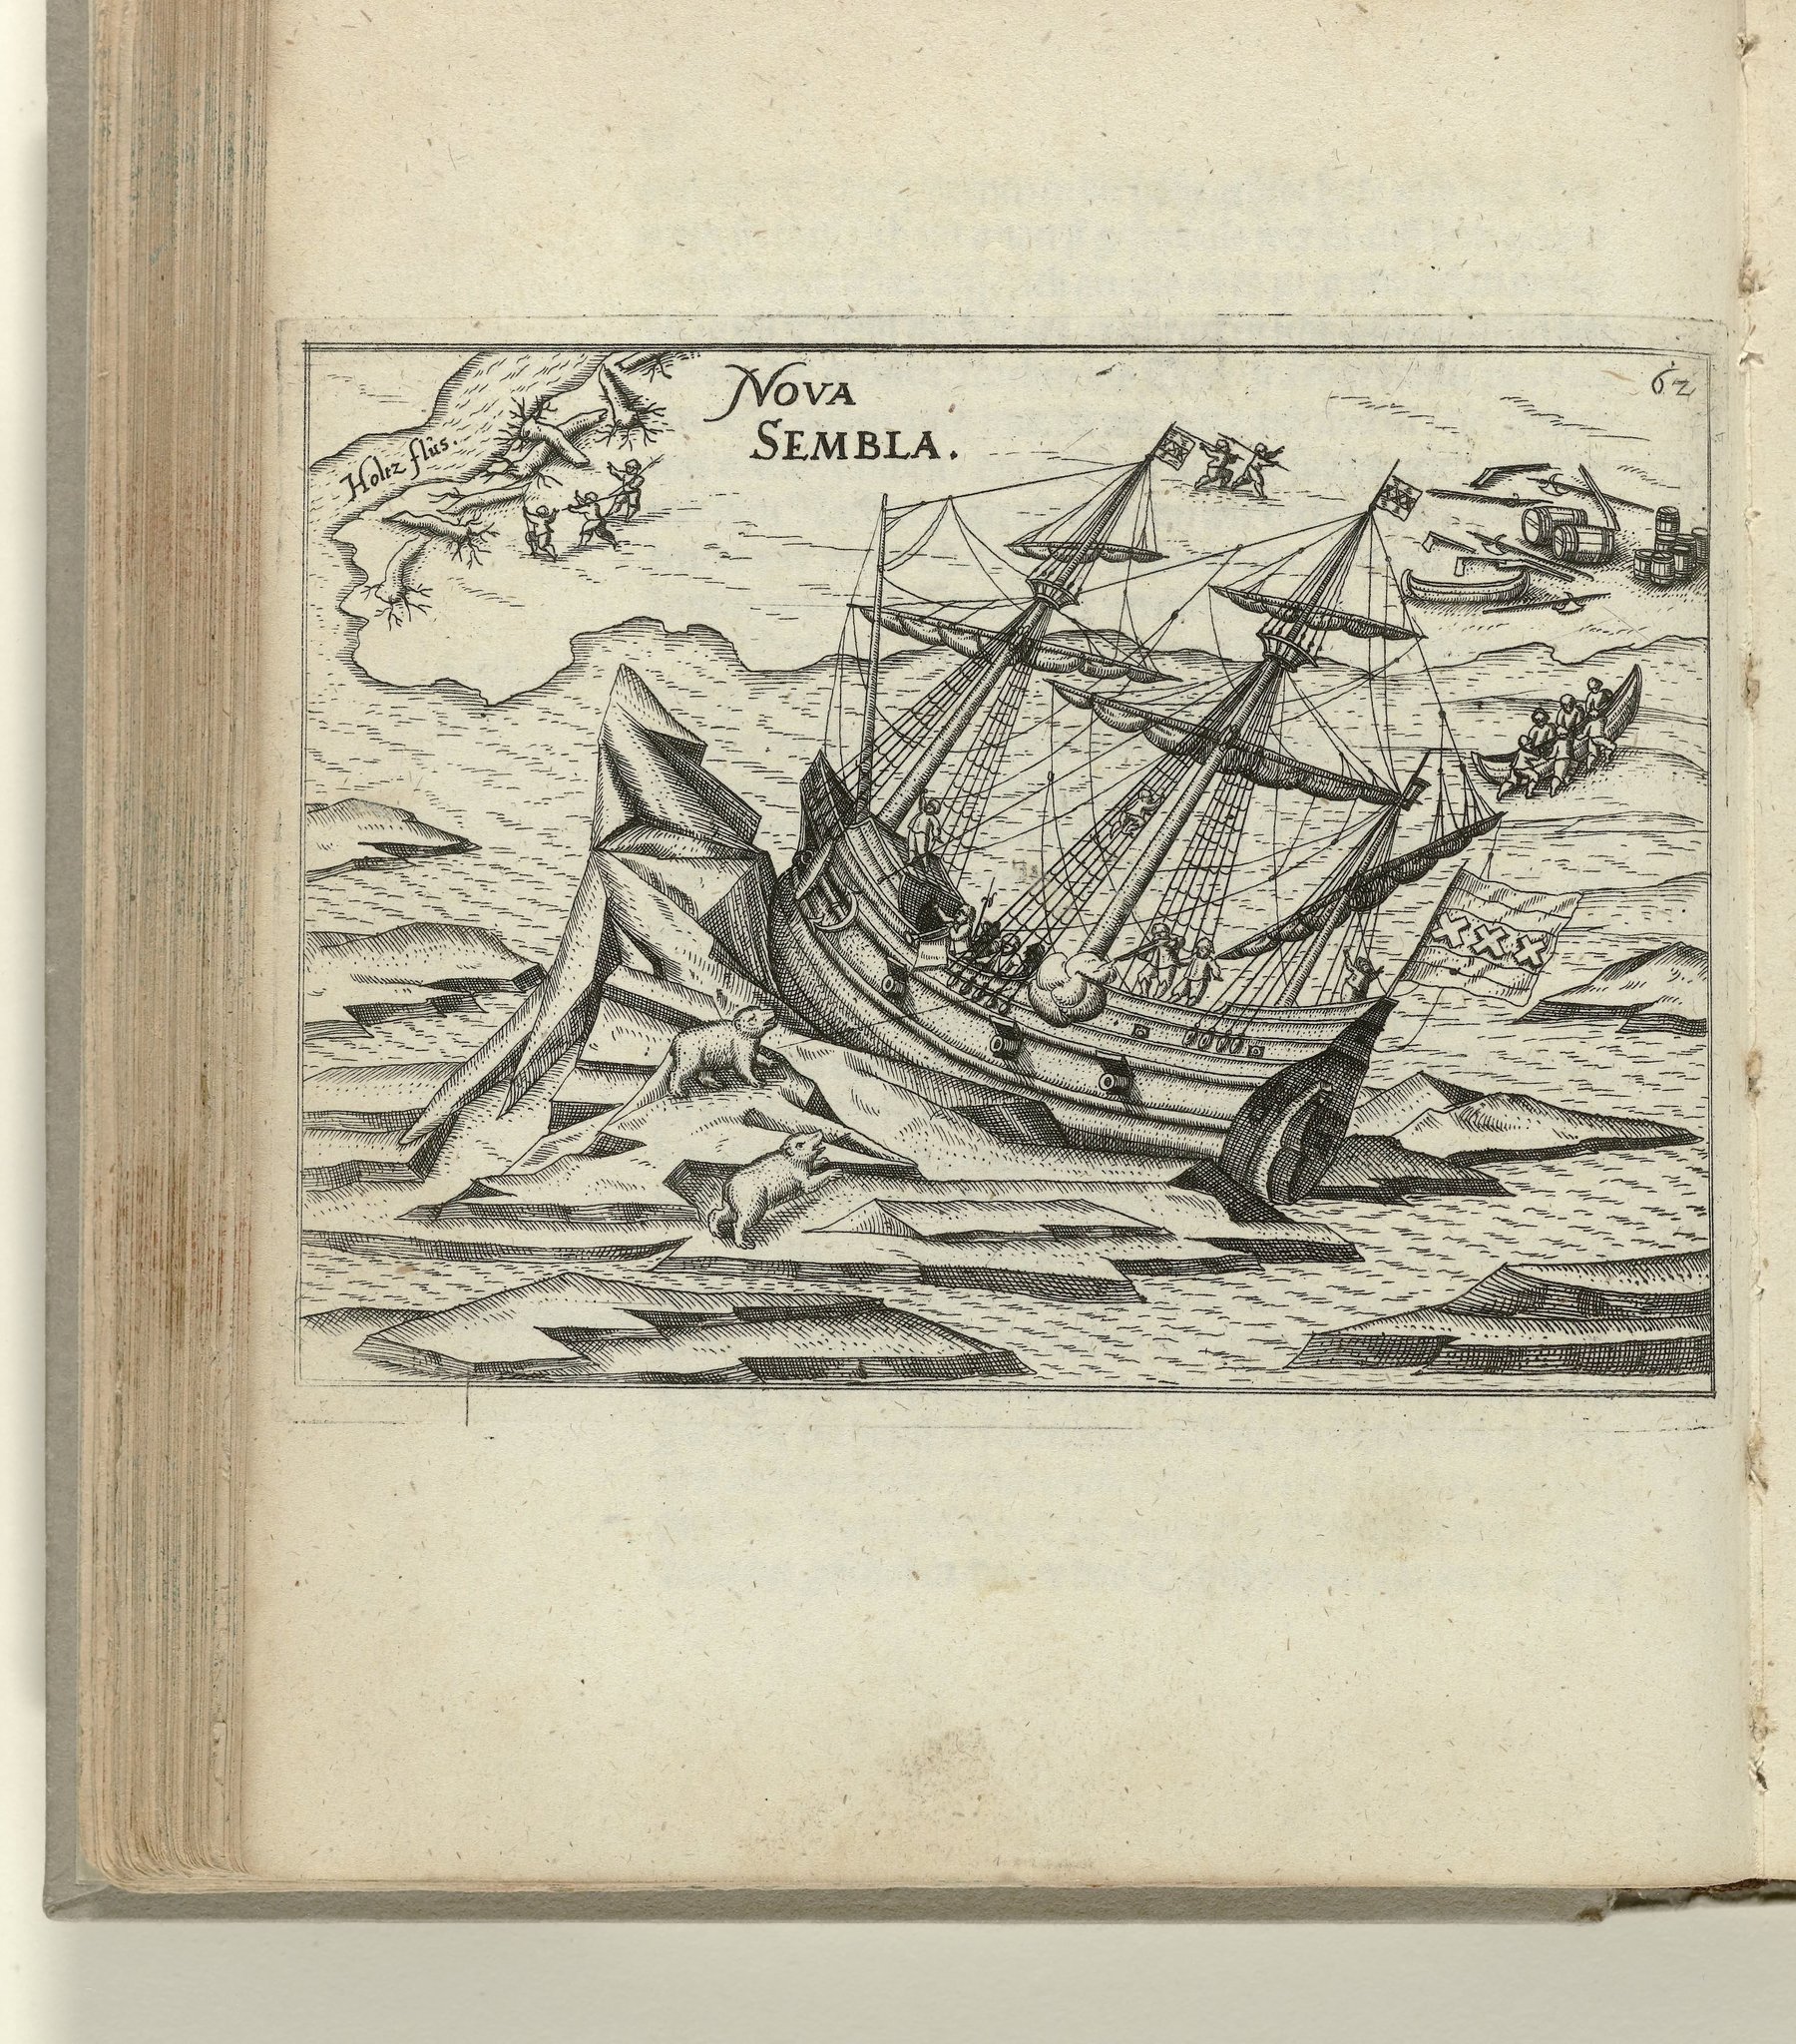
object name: print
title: Het schip vastgelopen in het ijs, 1596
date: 1598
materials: paper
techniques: engraving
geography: nuremberg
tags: willem barendsz., amsterdam, jacob van heemskerck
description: Op de voorgrond het schip waarvan de voorkant door kruiend ijs uit het water is getild. Rechts op de achtergrond brengen bemanningsleden de sloepen en voorraden aan land, links vinden de mannen aangespoelde bomen aan een rivieroever. Tegenover pagina 62 in: 'Warhafftige Relation. Der dreyen newen unerhörten seltzamen Schiffart so die Holländischen und Seeländischen Schiff....Anno 1594, 1595 und 1596 verricht' (1598).